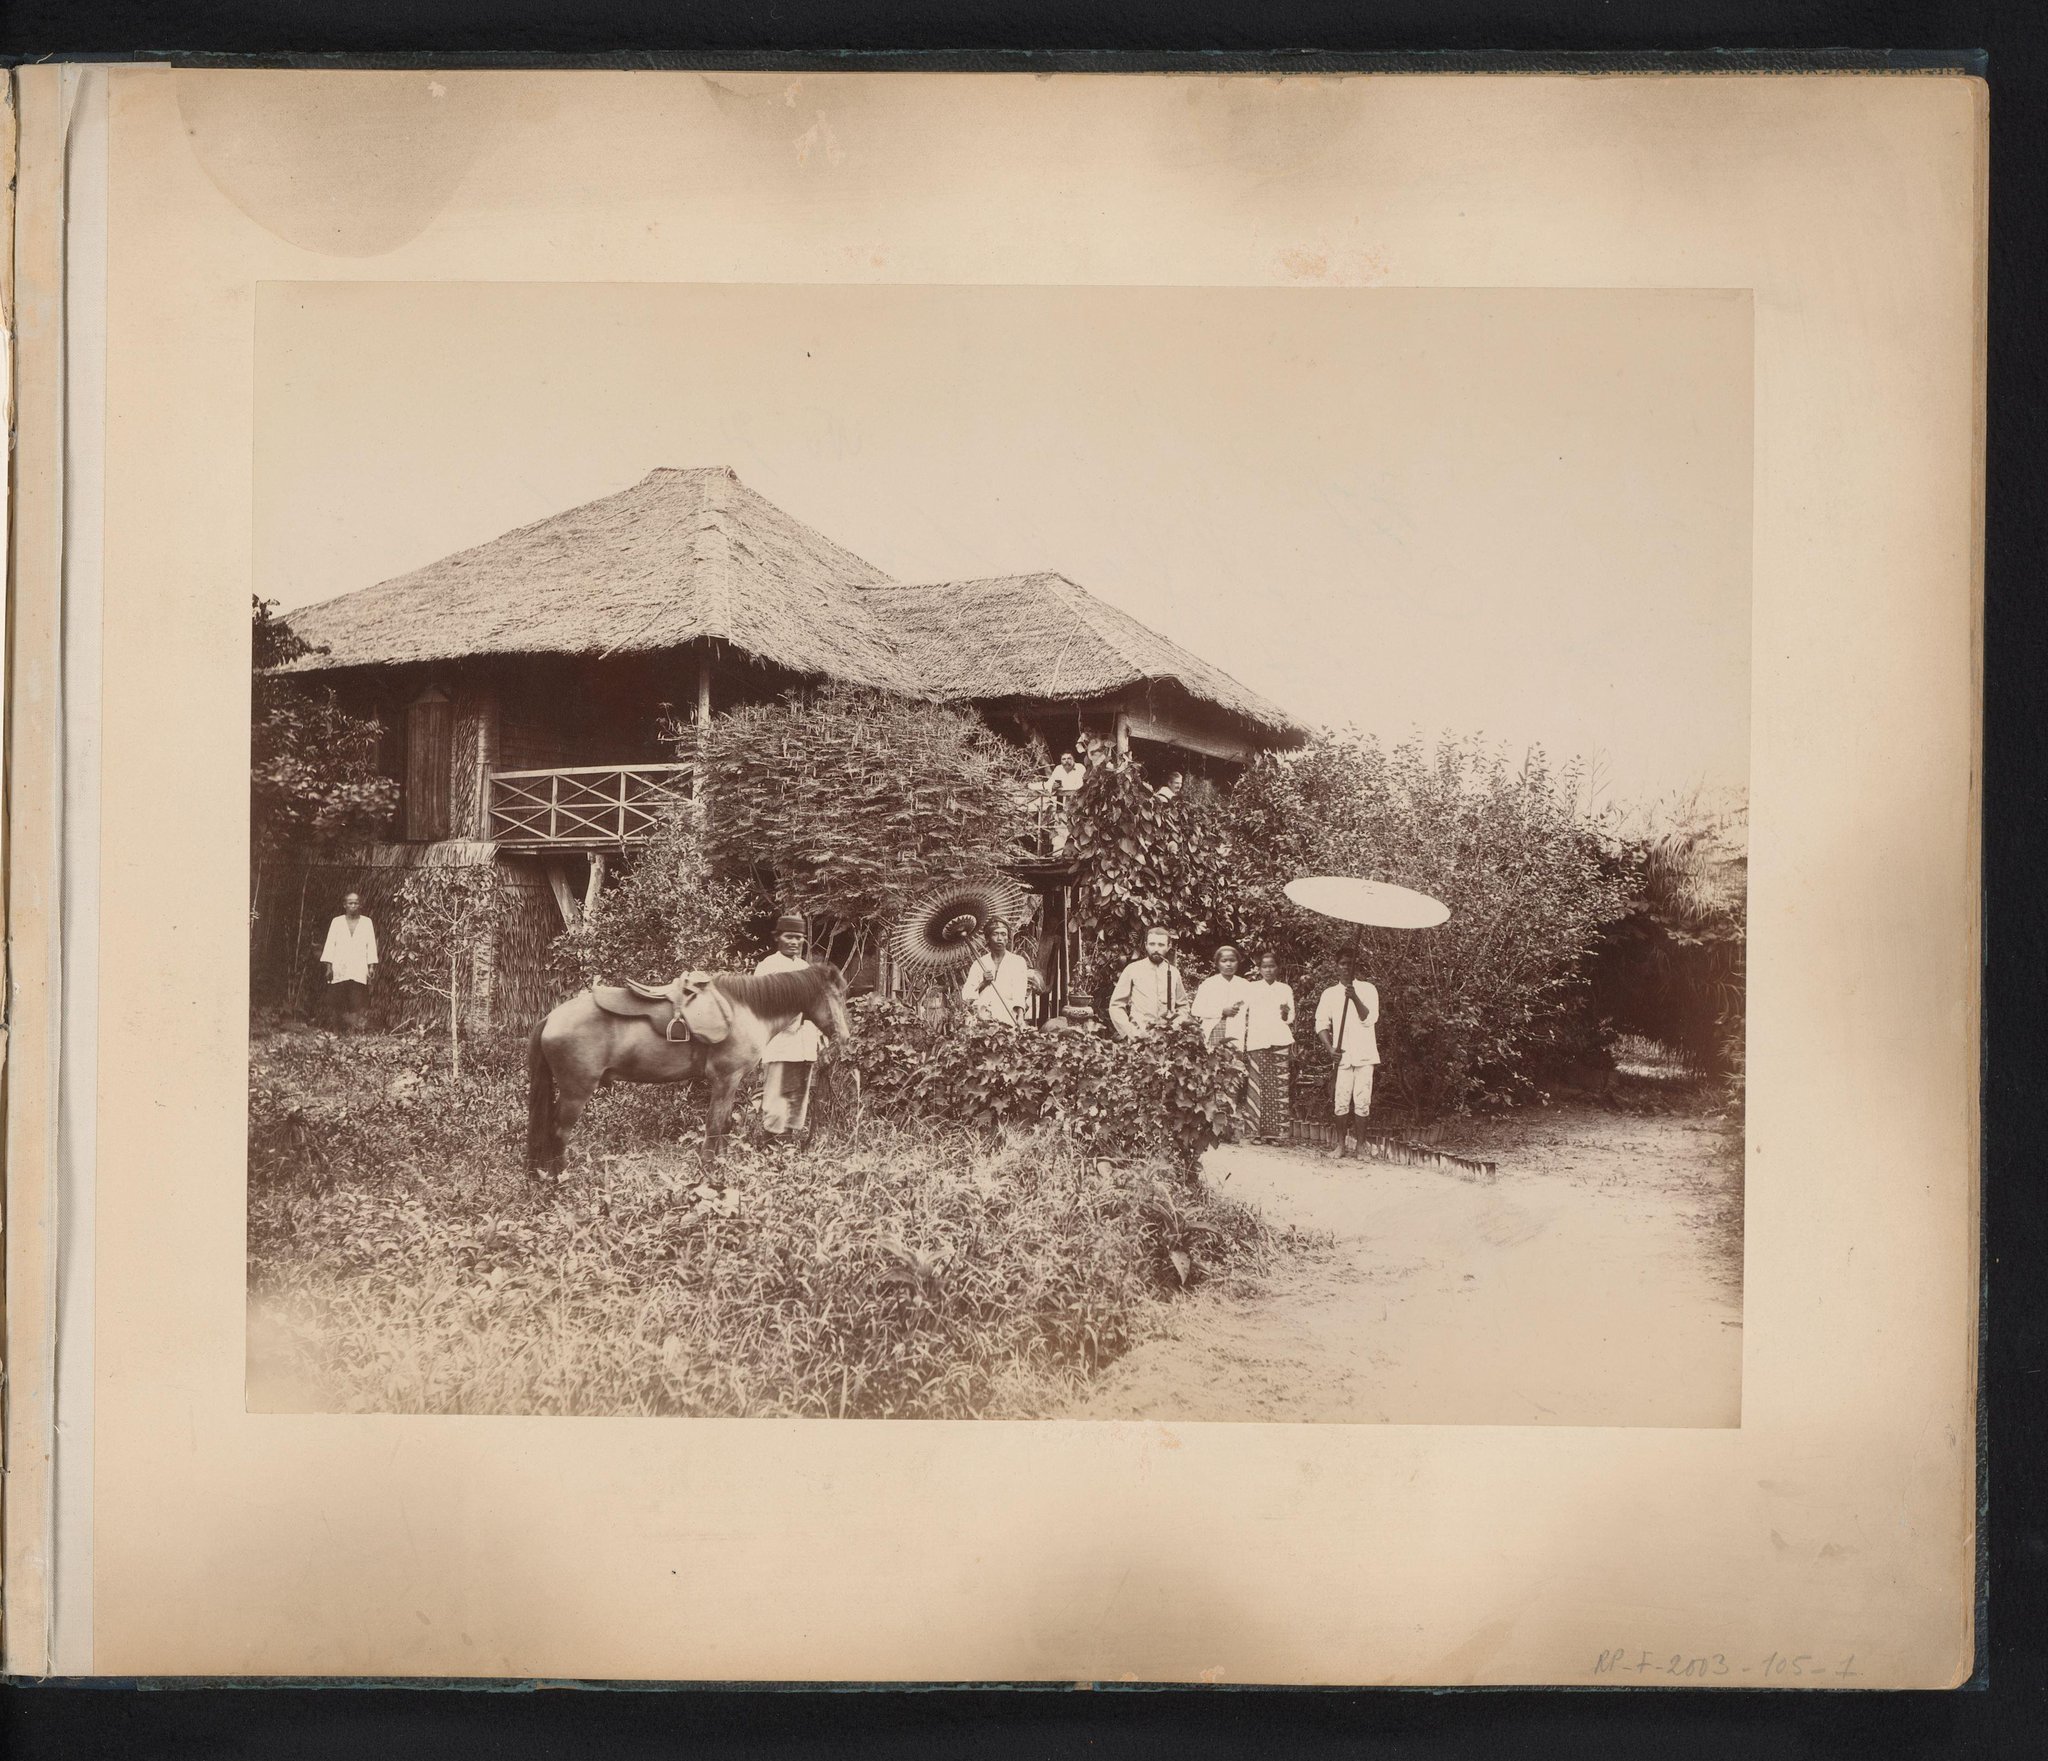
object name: album leaf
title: Europese planter voor zijn huis met bedienden, vermoedelijk in Langkat, Sumatra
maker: Anonymous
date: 1890-1900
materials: cardboard, photographic support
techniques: albumen print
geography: sumatra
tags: director, boss (in modern industry), rural housing, e.g. country-house, villa, cottage, house personnel, servants, sumatra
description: Europese man voor zijn huis met bedienden, vermoedelijk Langkat, Sumatra